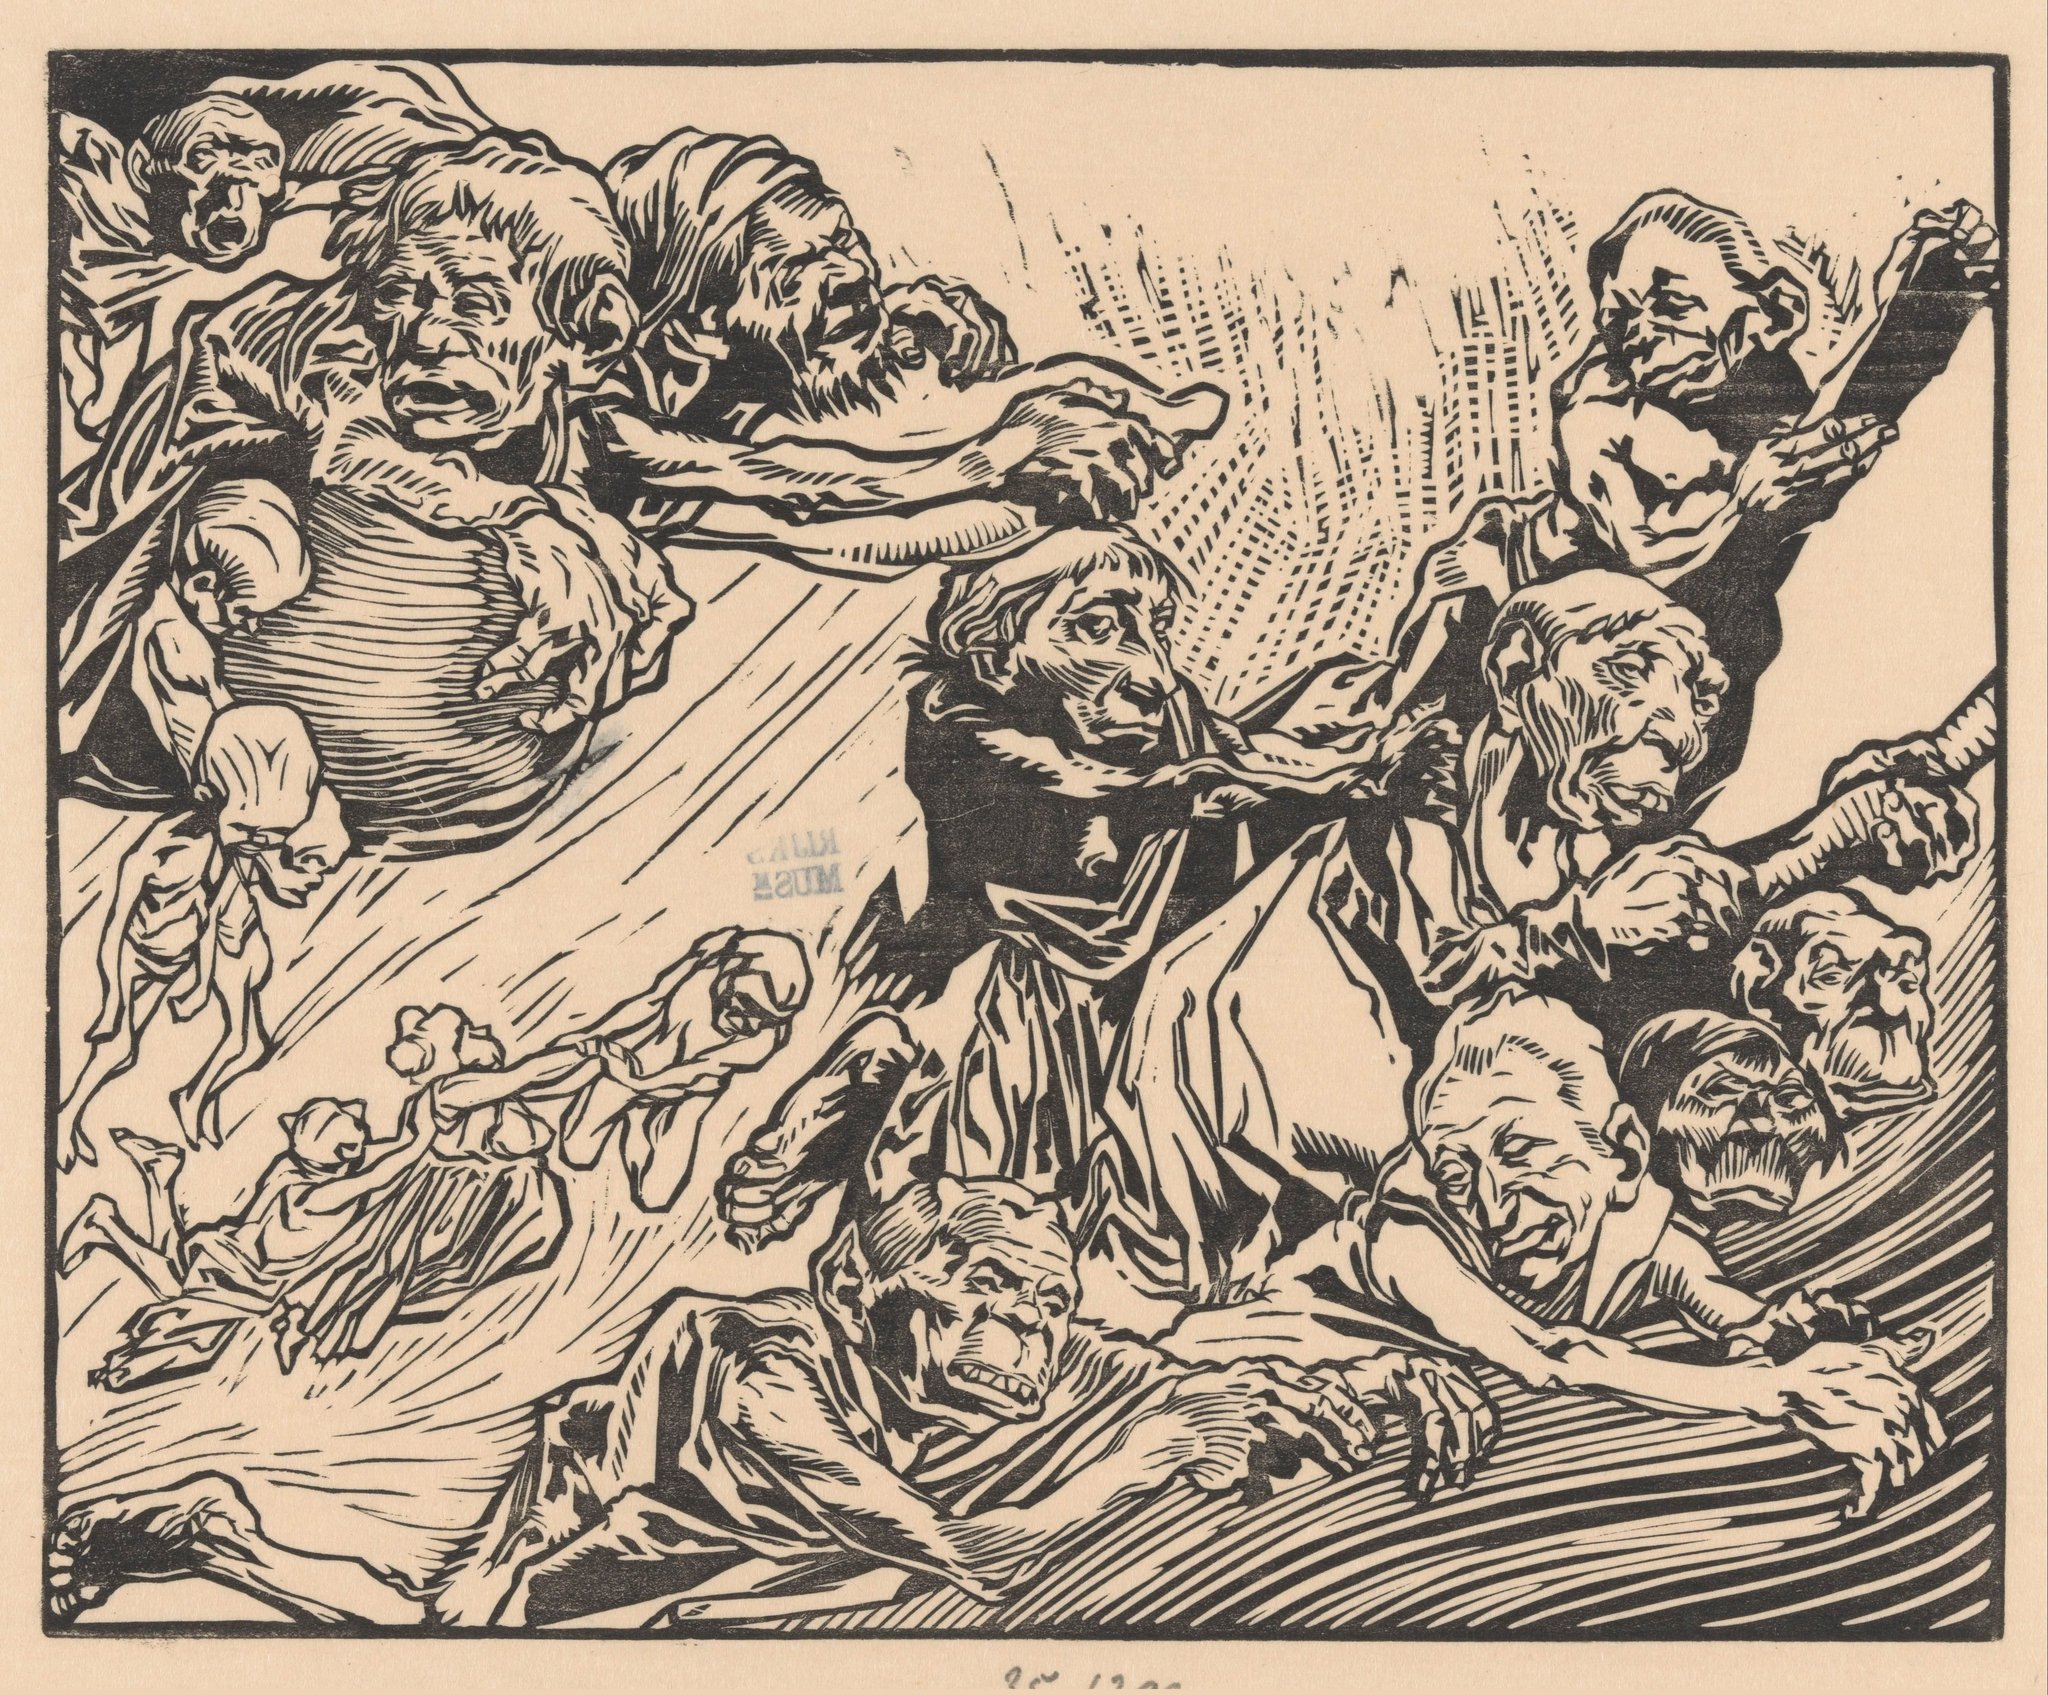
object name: print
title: Zwevende fantasiewezens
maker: johannes josephus aarts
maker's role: draughtsman, print maker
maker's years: 1871-1934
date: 1881-1934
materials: paper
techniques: woodcut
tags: movement in the air, surrealia, surrealistic representations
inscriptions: collector's mark: Lugt 2166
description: Verschillende groepen fantasiewezens bewegen zich voort door de lucht.